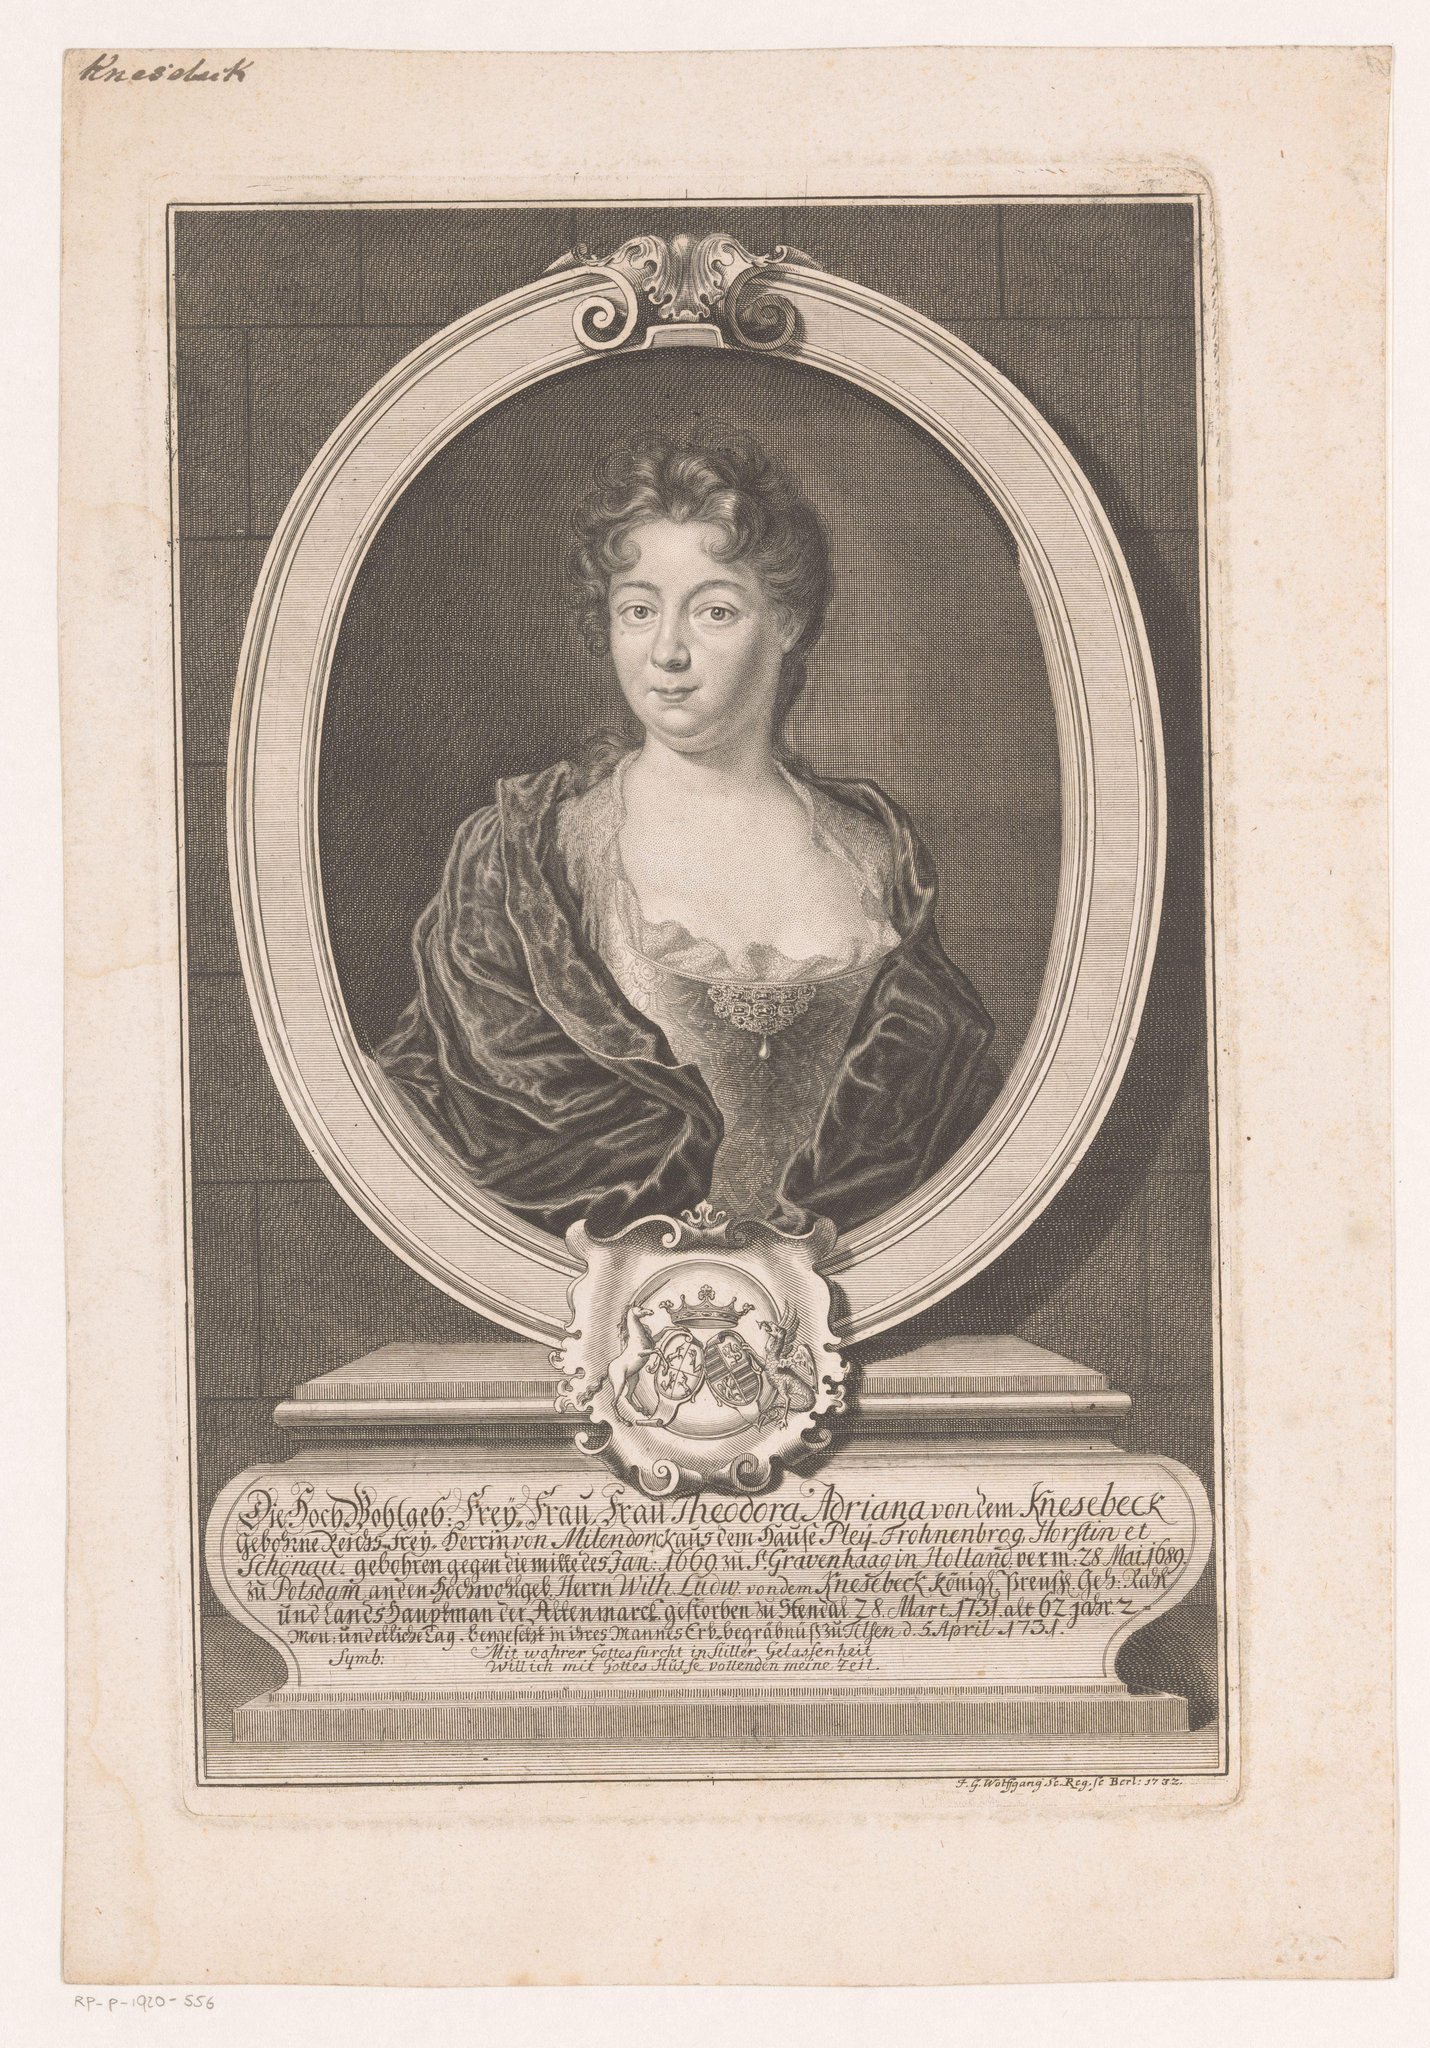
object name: print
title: Portret van Theodora Adriana von dem Knesebeck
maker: johann georg wolfgang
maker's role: graveur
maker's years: 1662-1744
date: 1732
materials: paper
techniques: engraving, etching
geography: berlin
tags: the hague, historical persons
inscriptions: collector's mark: Lugt 2228, inscription: ‘Knesebeck’